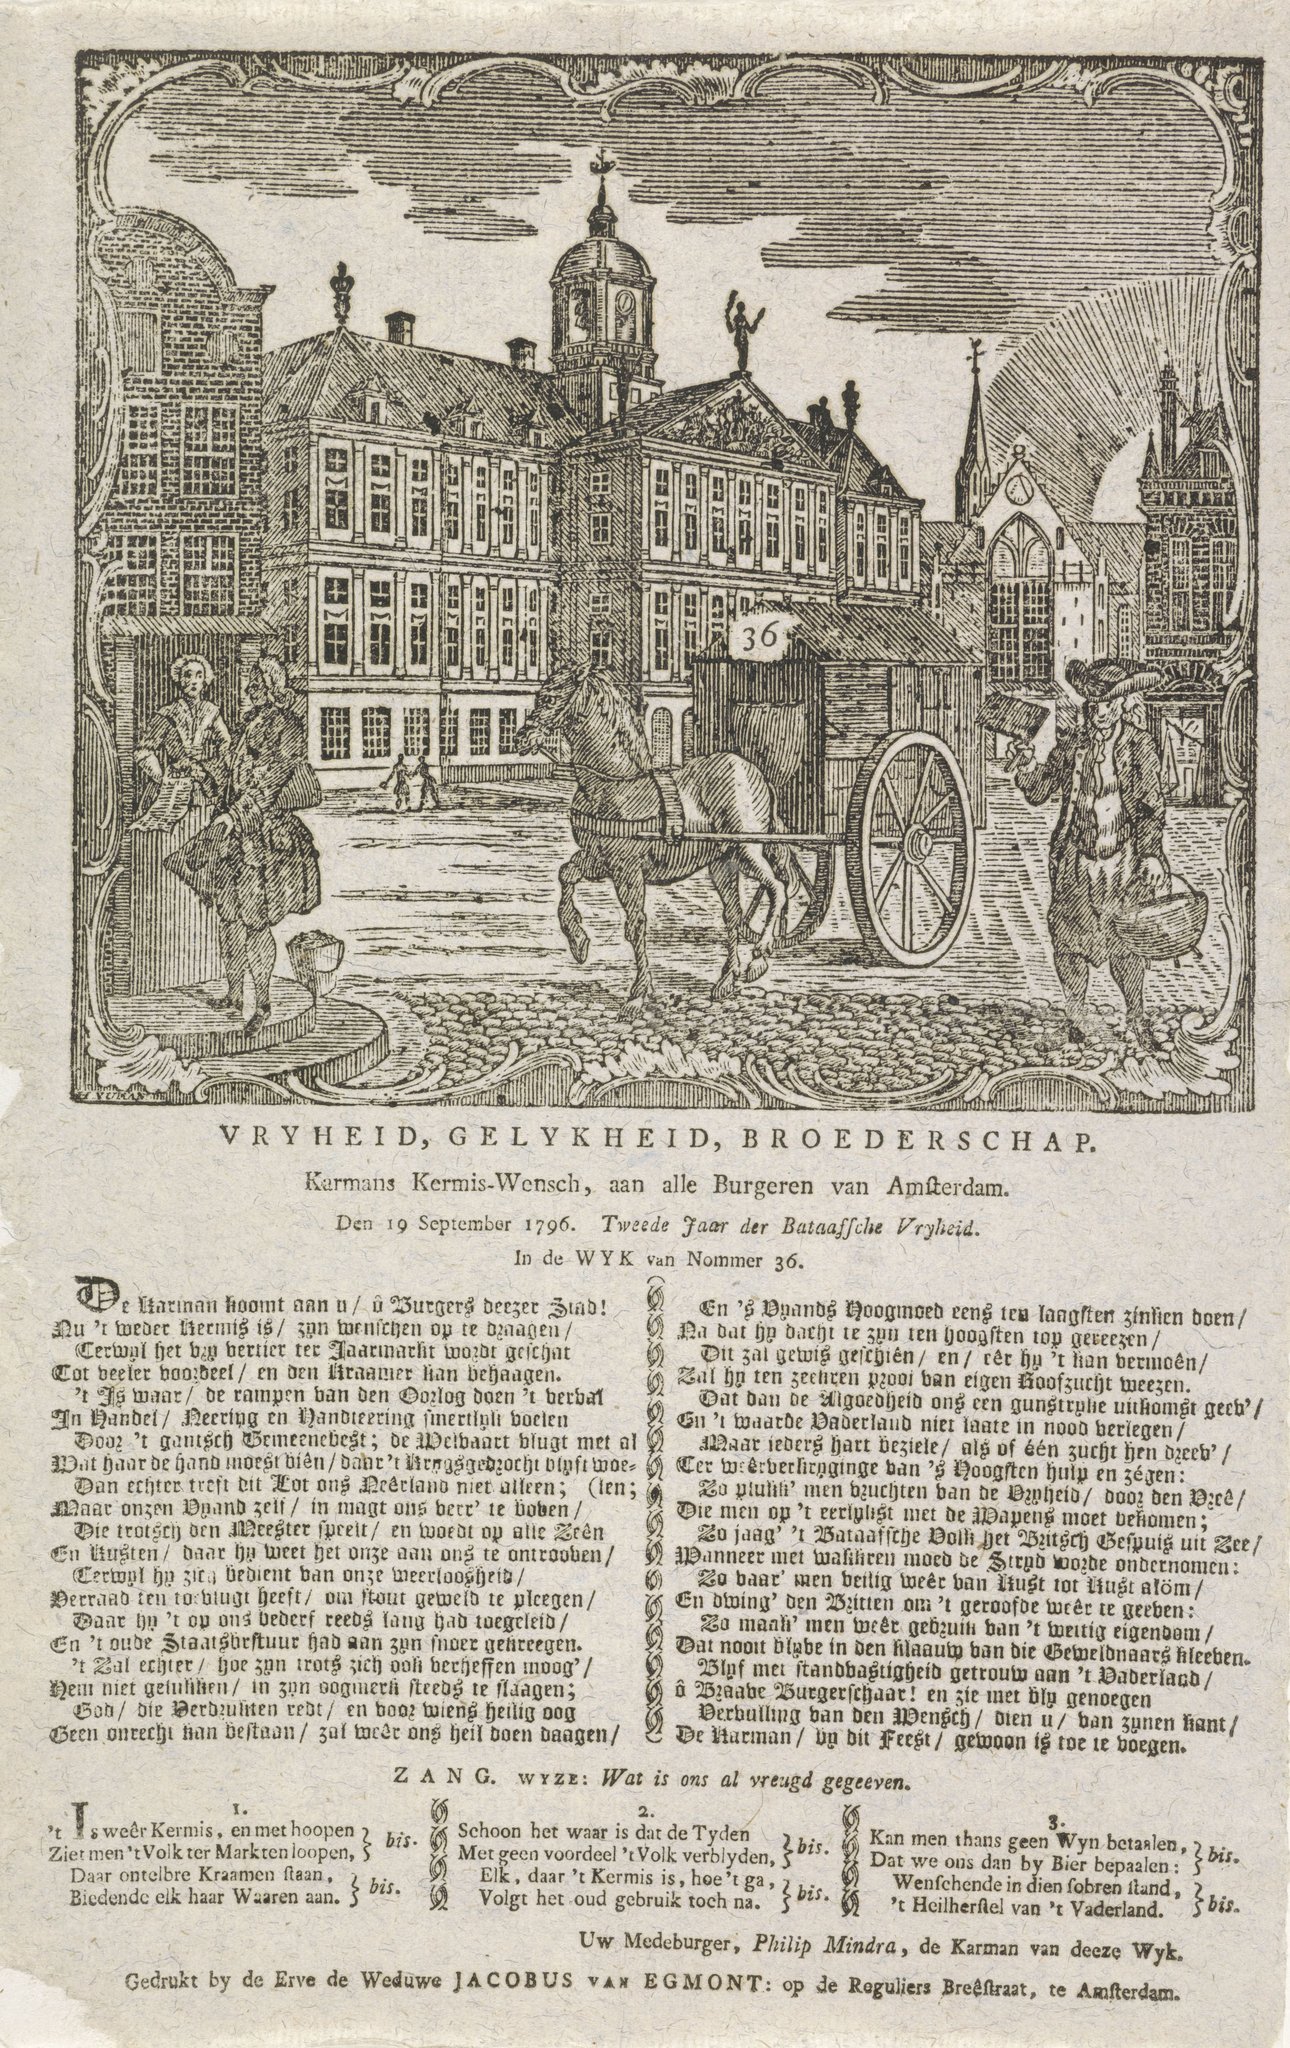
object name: print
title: Karmans Kermis-Wensch, aan alle Burgeren van Amsterdam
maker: hermanus numan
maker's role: draughtsman, painter, print maker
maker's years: 1744-1820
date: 1796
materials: paper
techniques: letterpress printing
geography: amsterdam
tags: garbage collecting lorry, garbage truck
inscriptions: collector's mark: Lugt 2228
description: Kermisprent voor het jaar 1796 van Philip Mindra, de karrenman (askarrenman of vuilnisman) in de wijk 36, opgedragen aan de burgers van Amsterdam. Paard met askar gemerkt 36 op de Dam voor het Stadhuis. Op het blad onder de voorstelling een vers in twee kolommen met daaronder een lied in drie kolommen.